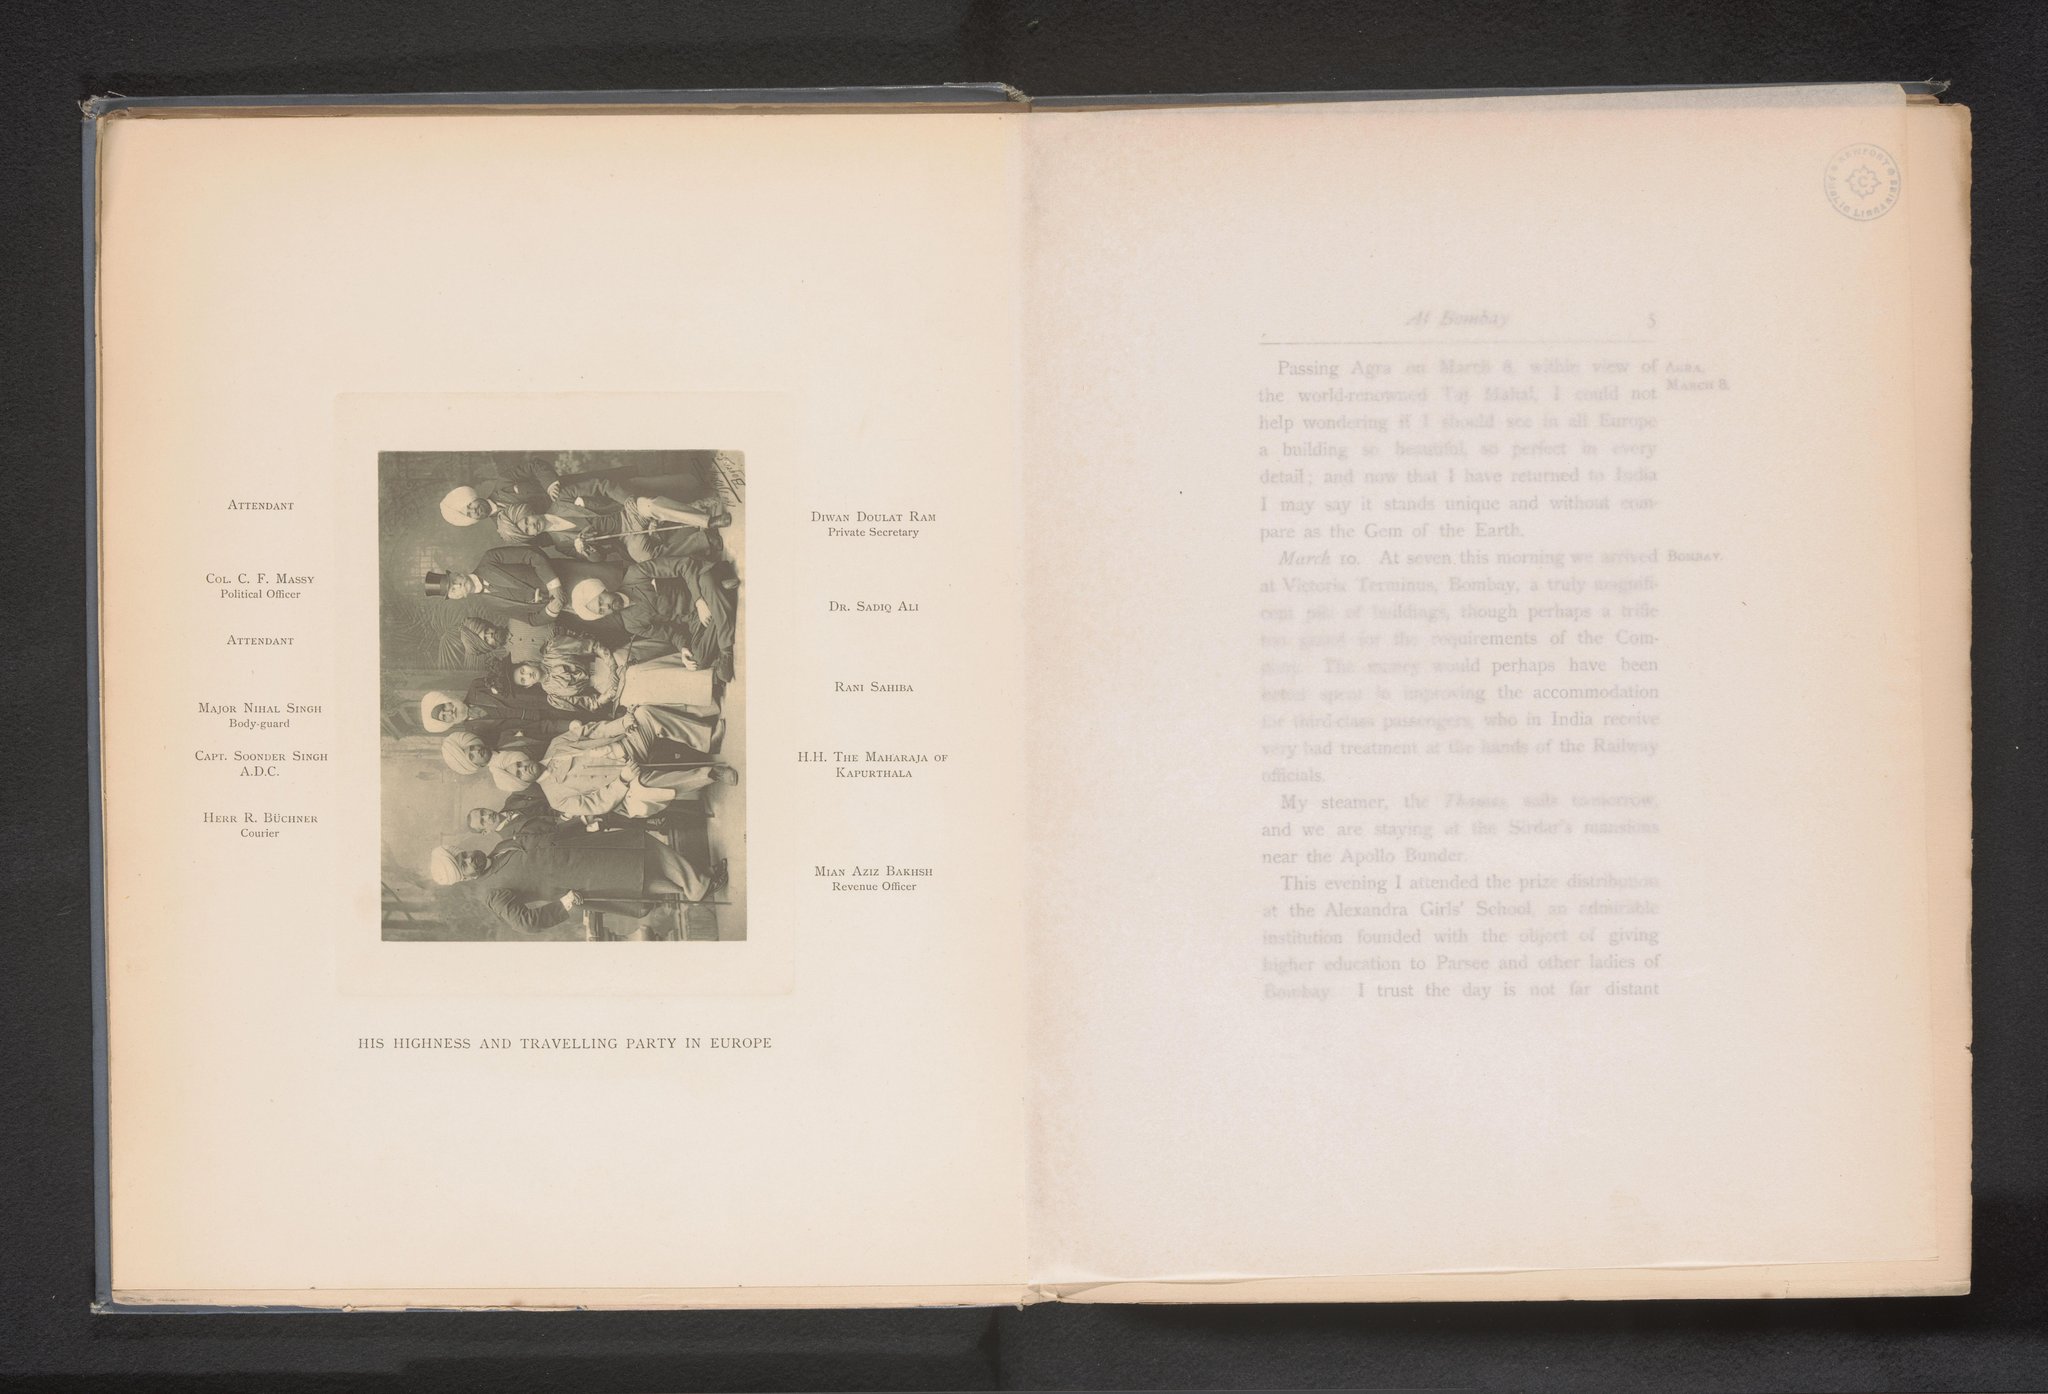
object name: page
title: Groepsportret van Jagatjit Singh en zijn gevolg in Europa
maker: Anonymous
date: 1893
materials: photographic support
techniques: carbon print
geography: europe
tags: ruler, sovereign, house personnel, servants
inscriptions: inscription